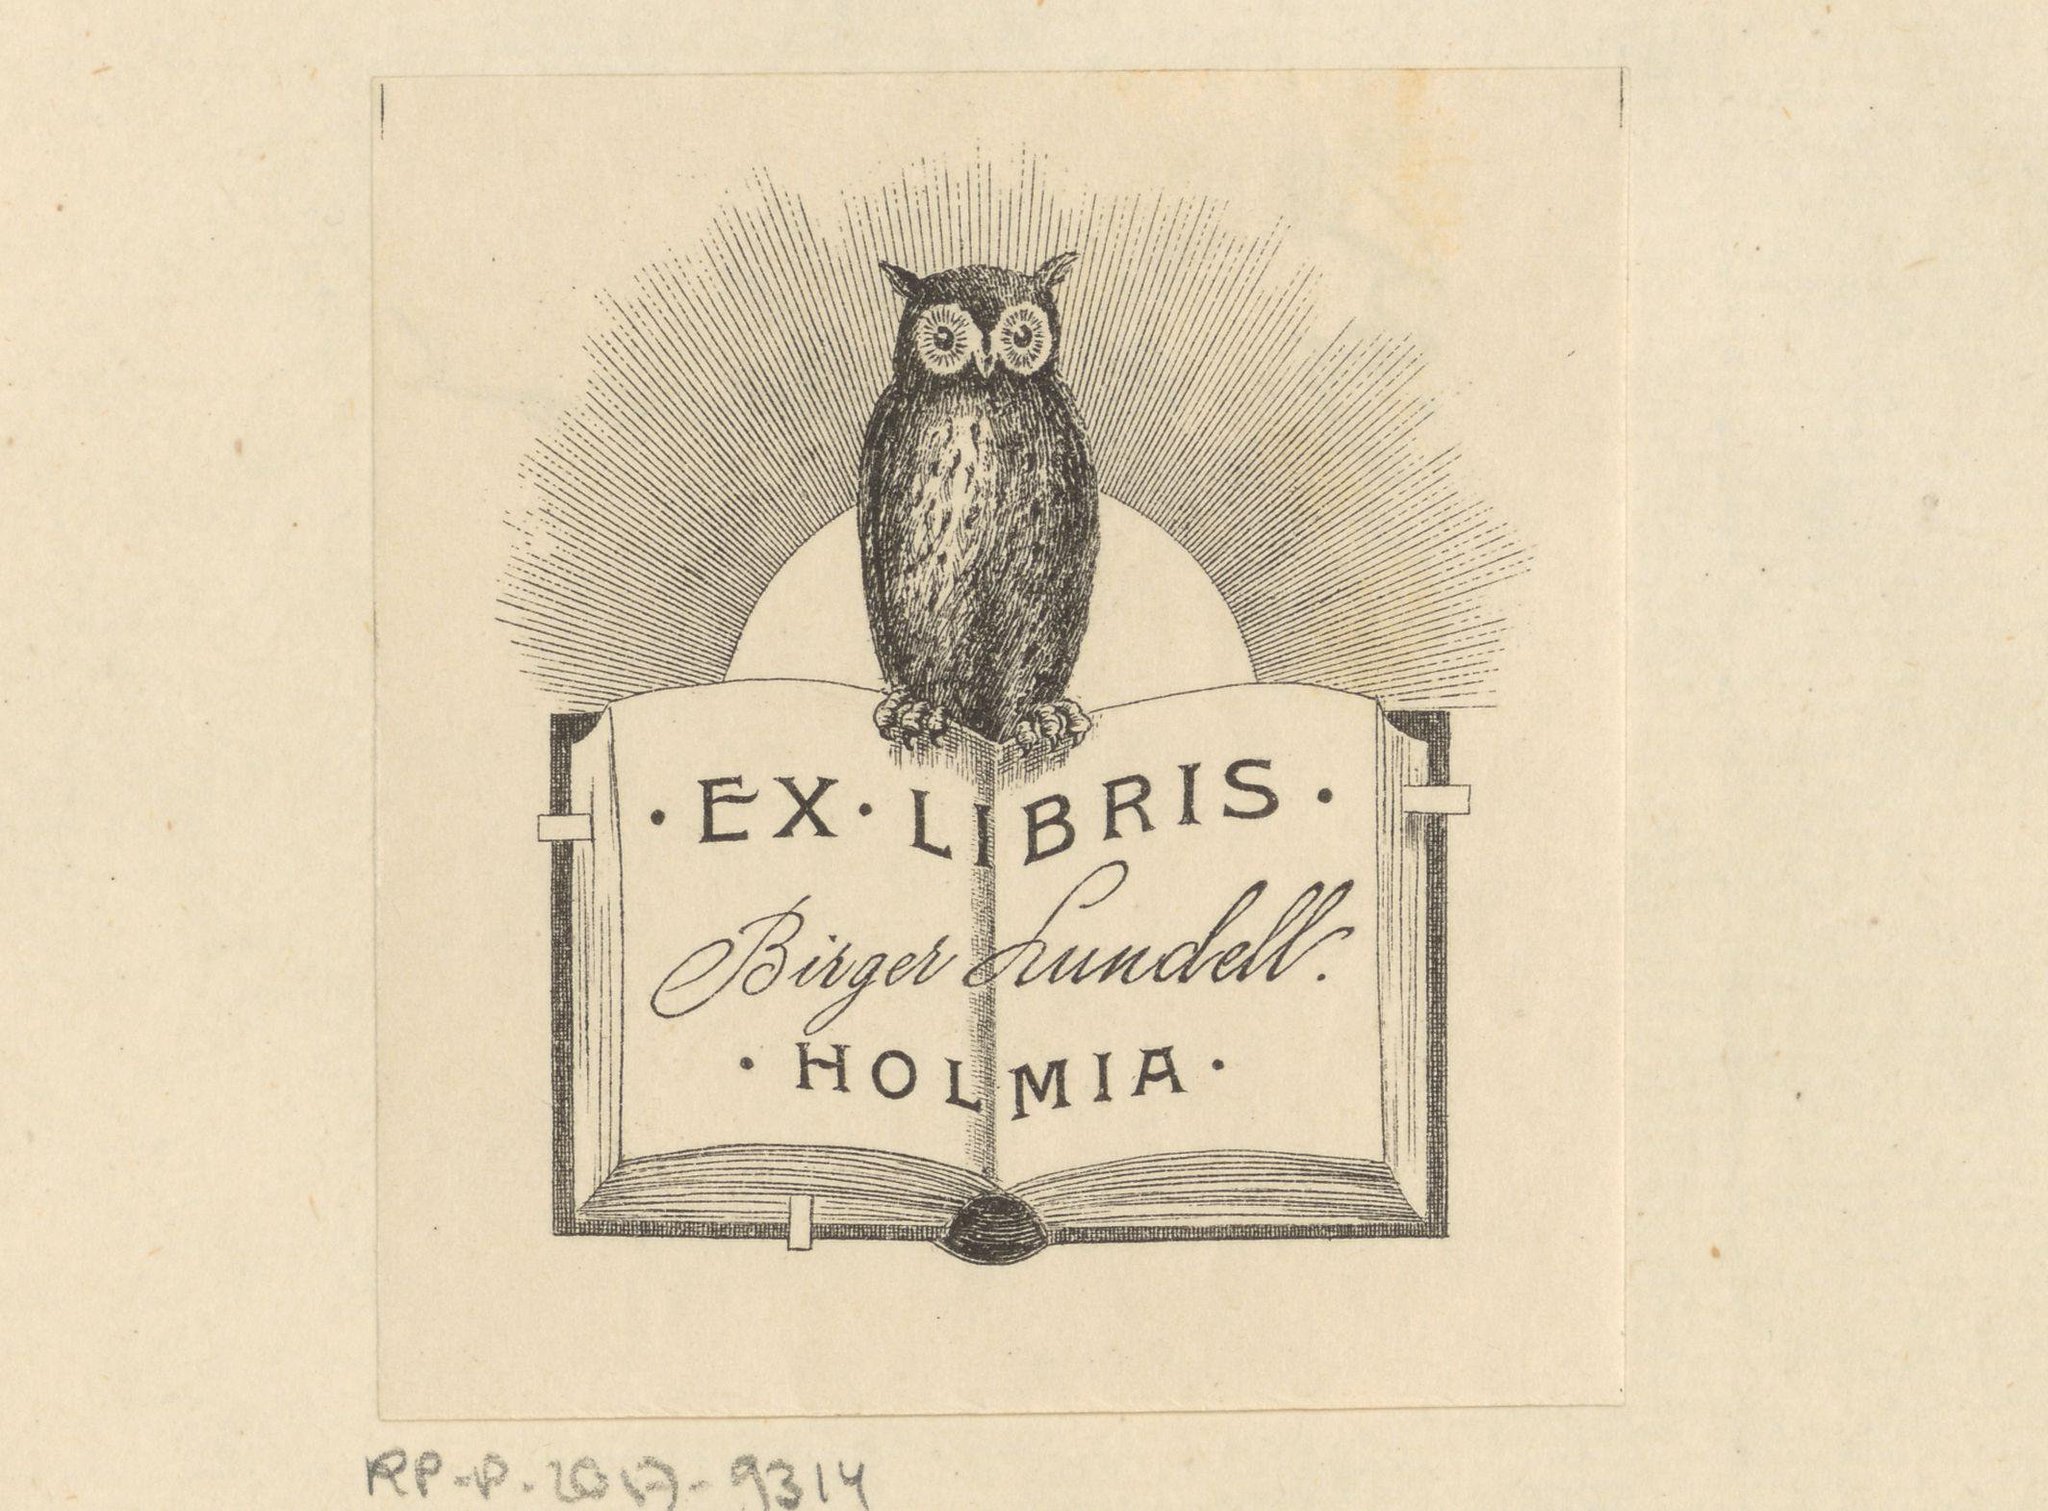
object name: bookplate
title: Ex libris van Birger Lundell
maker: Anonymous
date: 1870-1949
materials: paper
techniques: printing block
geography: sweden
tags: book, owls